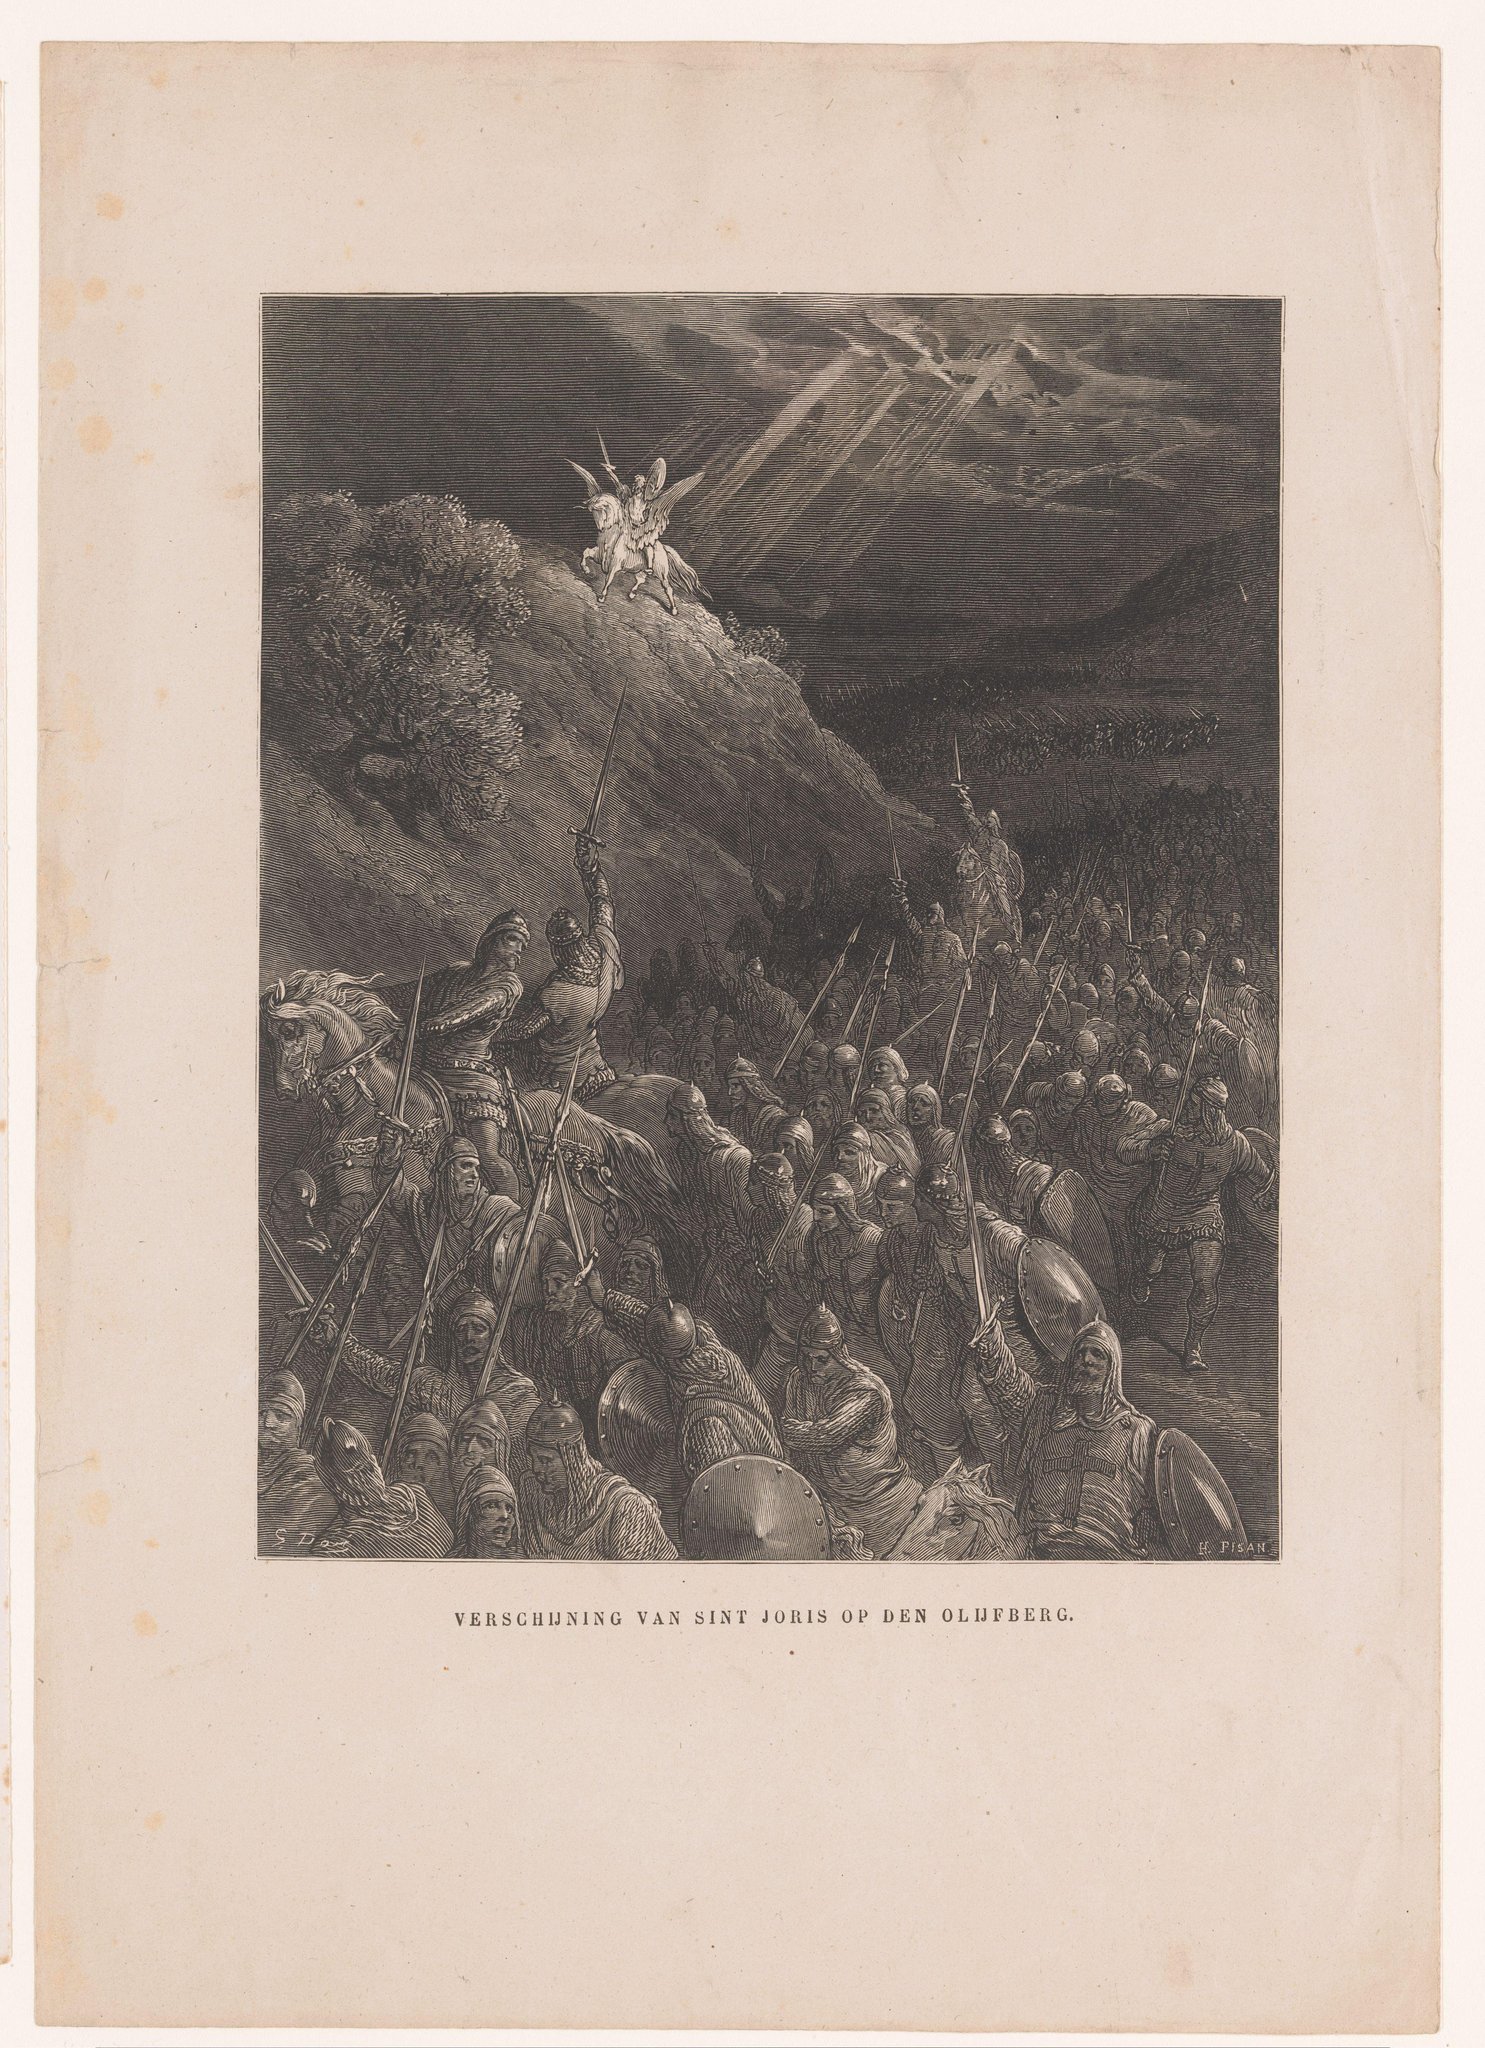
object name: print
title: Verschijning van de heilige Joris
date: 1879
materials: paper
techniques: engraving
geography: amsterdam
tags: militant proselytizing: religious war, crusade, etc., the warrior martyr george (georgius); possible attributes: banner (red cross on white field), (red) cross, dragon, (white) horse, broken lance, shield (with cross), sword, knight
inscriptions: collector's mark: Lugt 2228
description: Prent uit: Michaud, Joseph François. Geschiedenis der Kruistochten. Amsterdam: Henri Bogaerts, 1879.